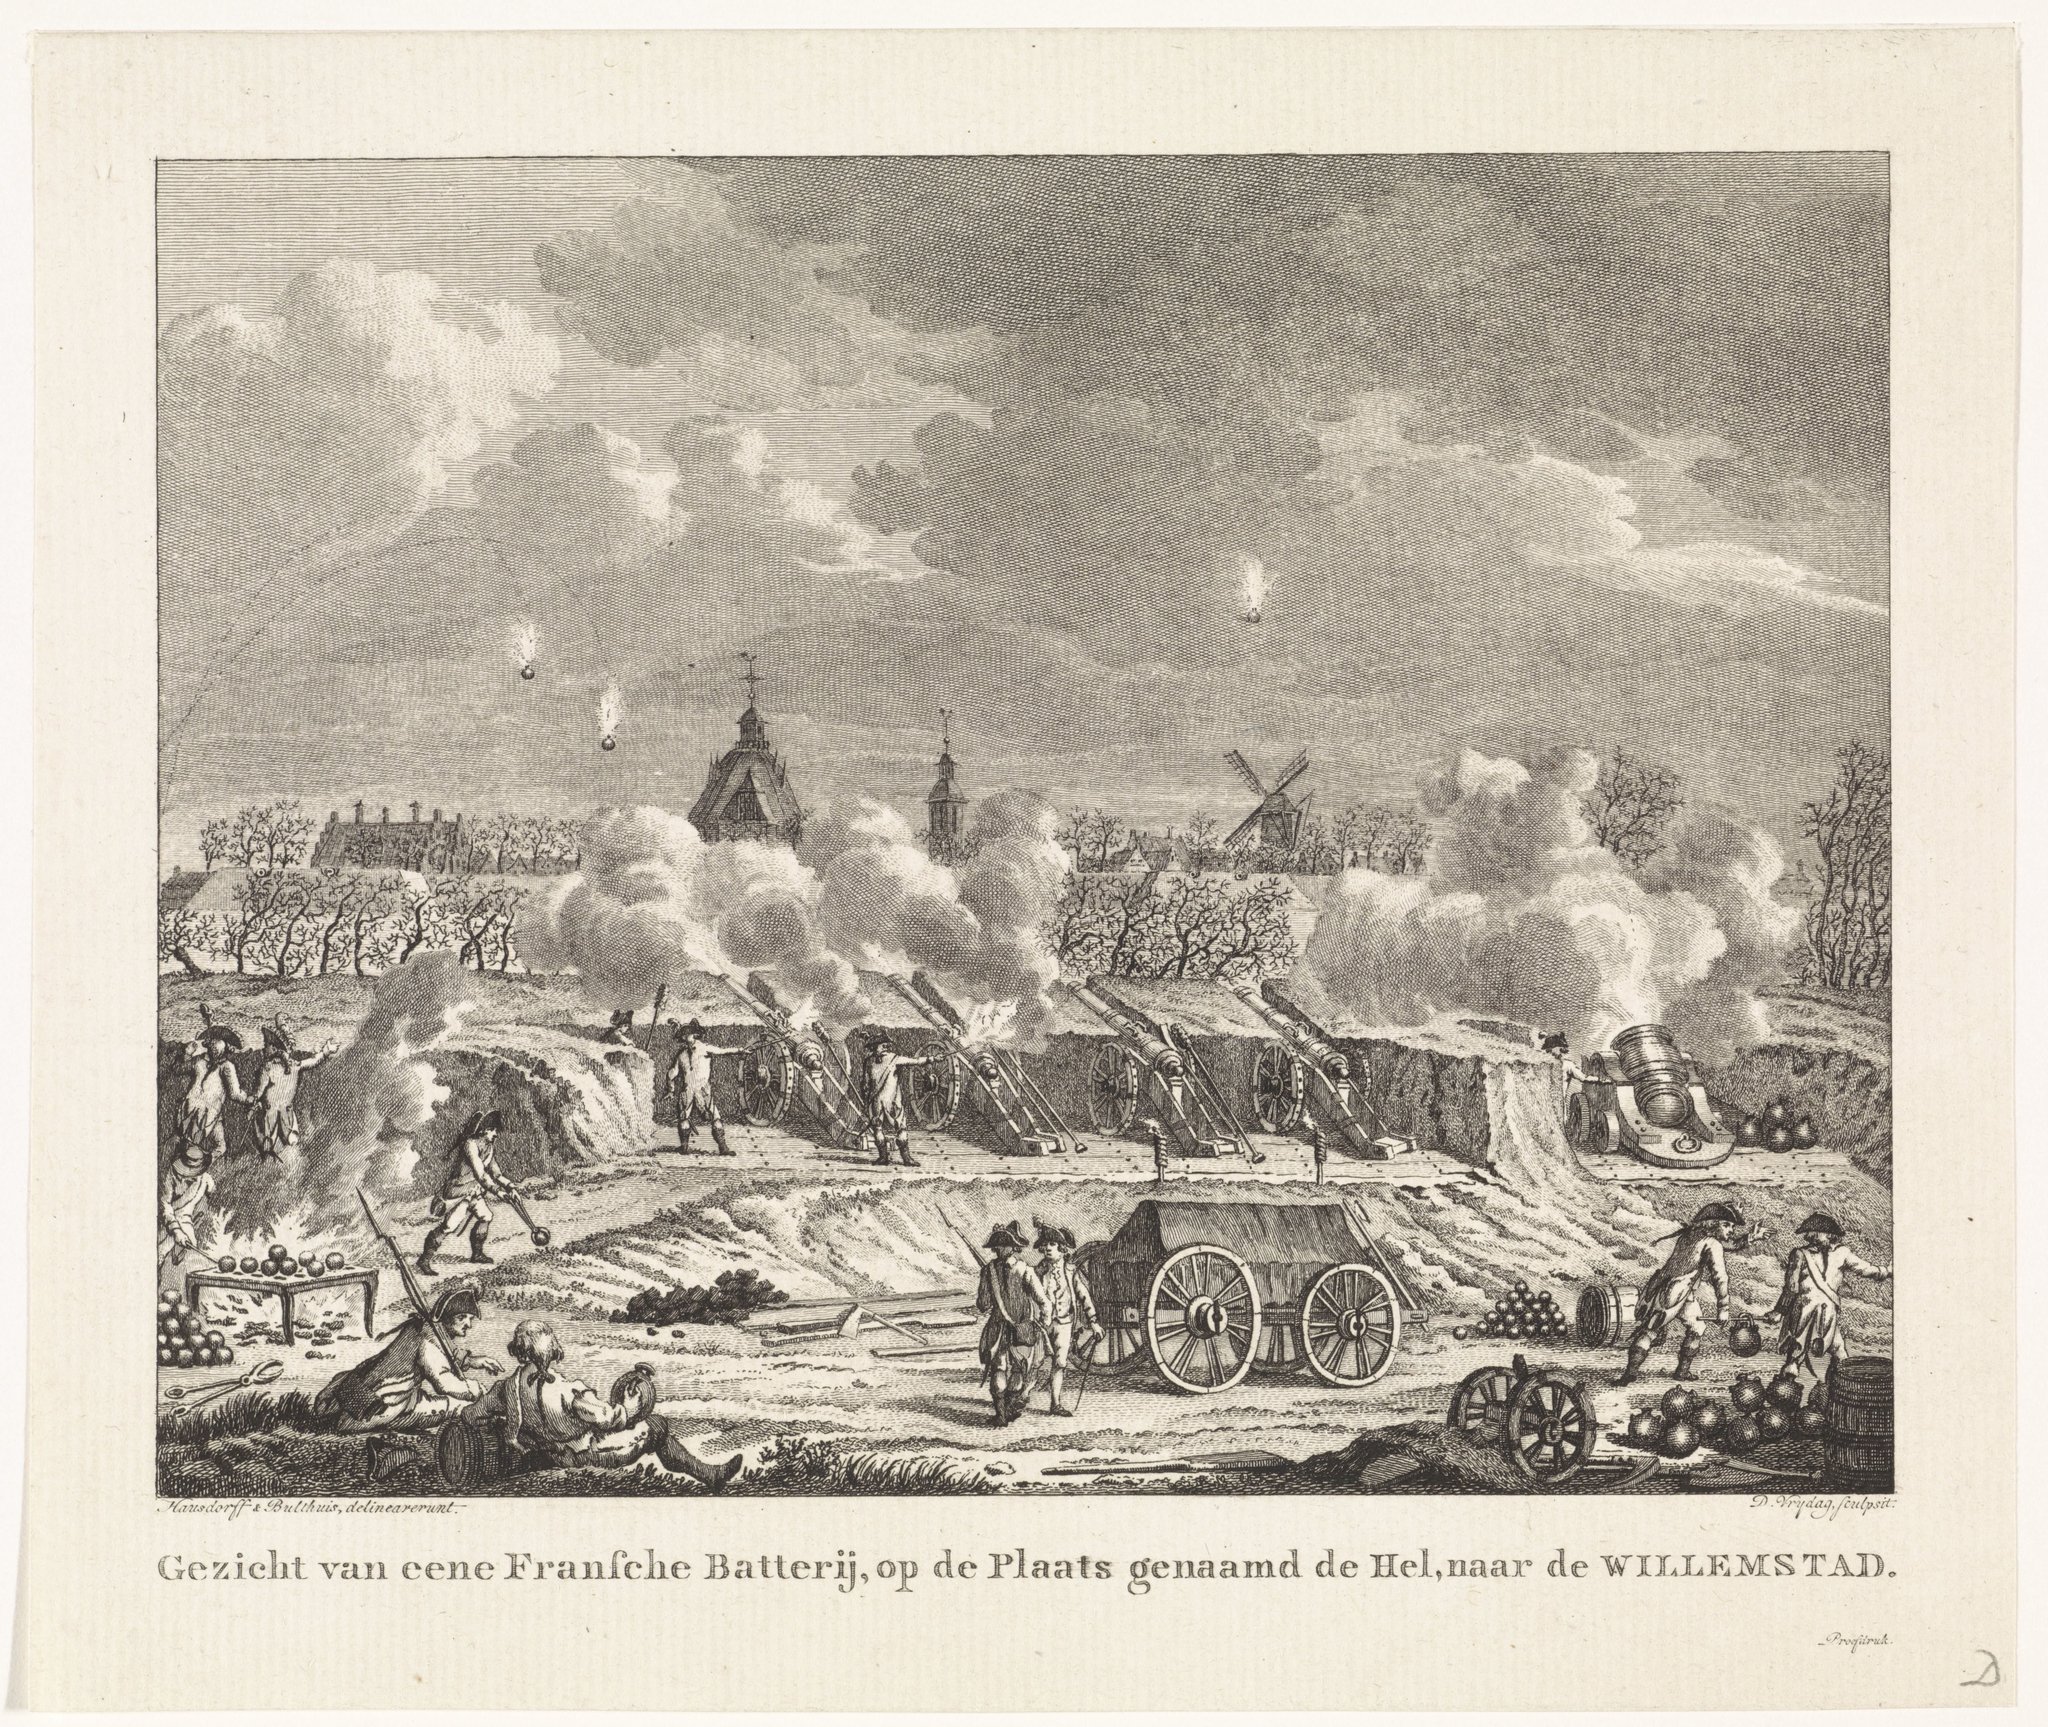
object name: print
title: Beschieting van Willemstad door een Franse batterij genaamd de Hel, 1793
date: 1793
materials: paper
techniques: engraving, etching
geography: netherlands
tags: bombardment ~ siege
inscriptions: collector's mark: Lugt 2228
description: Huidige staat van prent ook gebruikt in: Oldenborgh, Pieter van. De belegering en verdediging van de Willemstad, in maart MDCCXCIII. 1e druk. Dordrecht en Amsterdam: Abraham Blussé en Zoon en Johannes Allart, 1793. Latere staat van prent (zie RP-P-AO-14-79-2 en RP-P-OB-86.253) ook gebruikt in: Oldenborgh, Pieter van. De belegering en verdediging van de Willemstad, in maart MDCCXCIII. 2e druk. Dordrecht en Amsterdam: Abraham Blussé en Zoon en Johannes Allart, 1793.